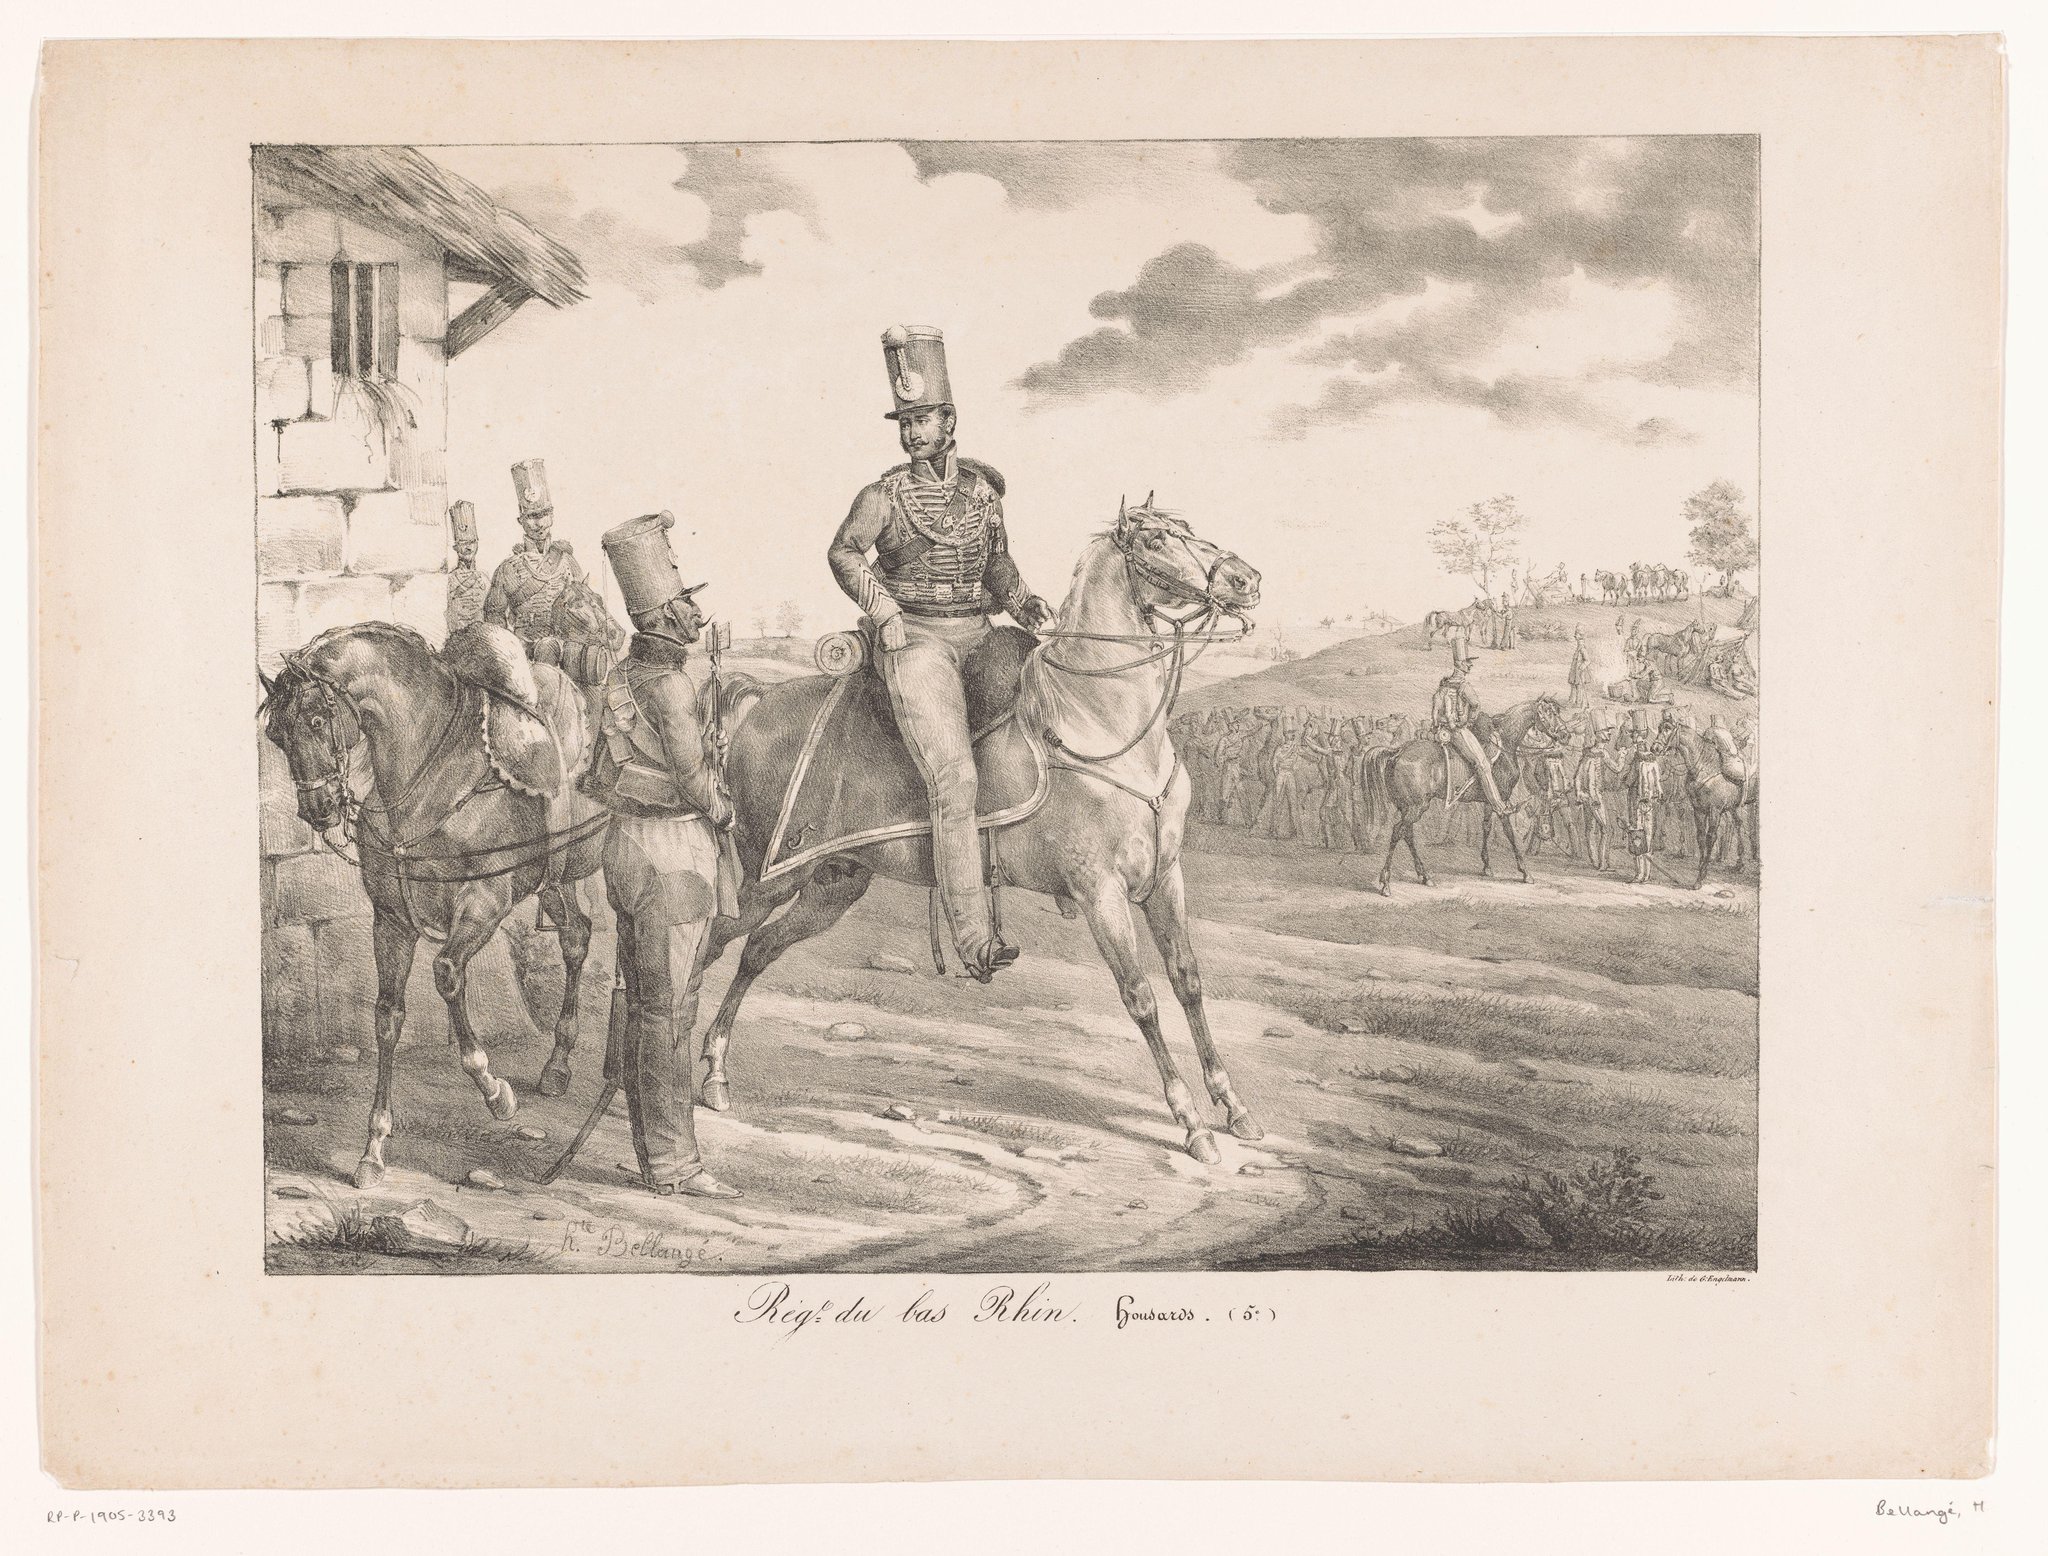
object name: print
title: Huzaren te paard uit het regiment Bas-Rhin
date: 1820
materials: paper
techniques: lithography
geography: paris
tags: land forces (+ cavalry, horsemen), private soldier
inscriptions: collector's mark: Lugt 2228a